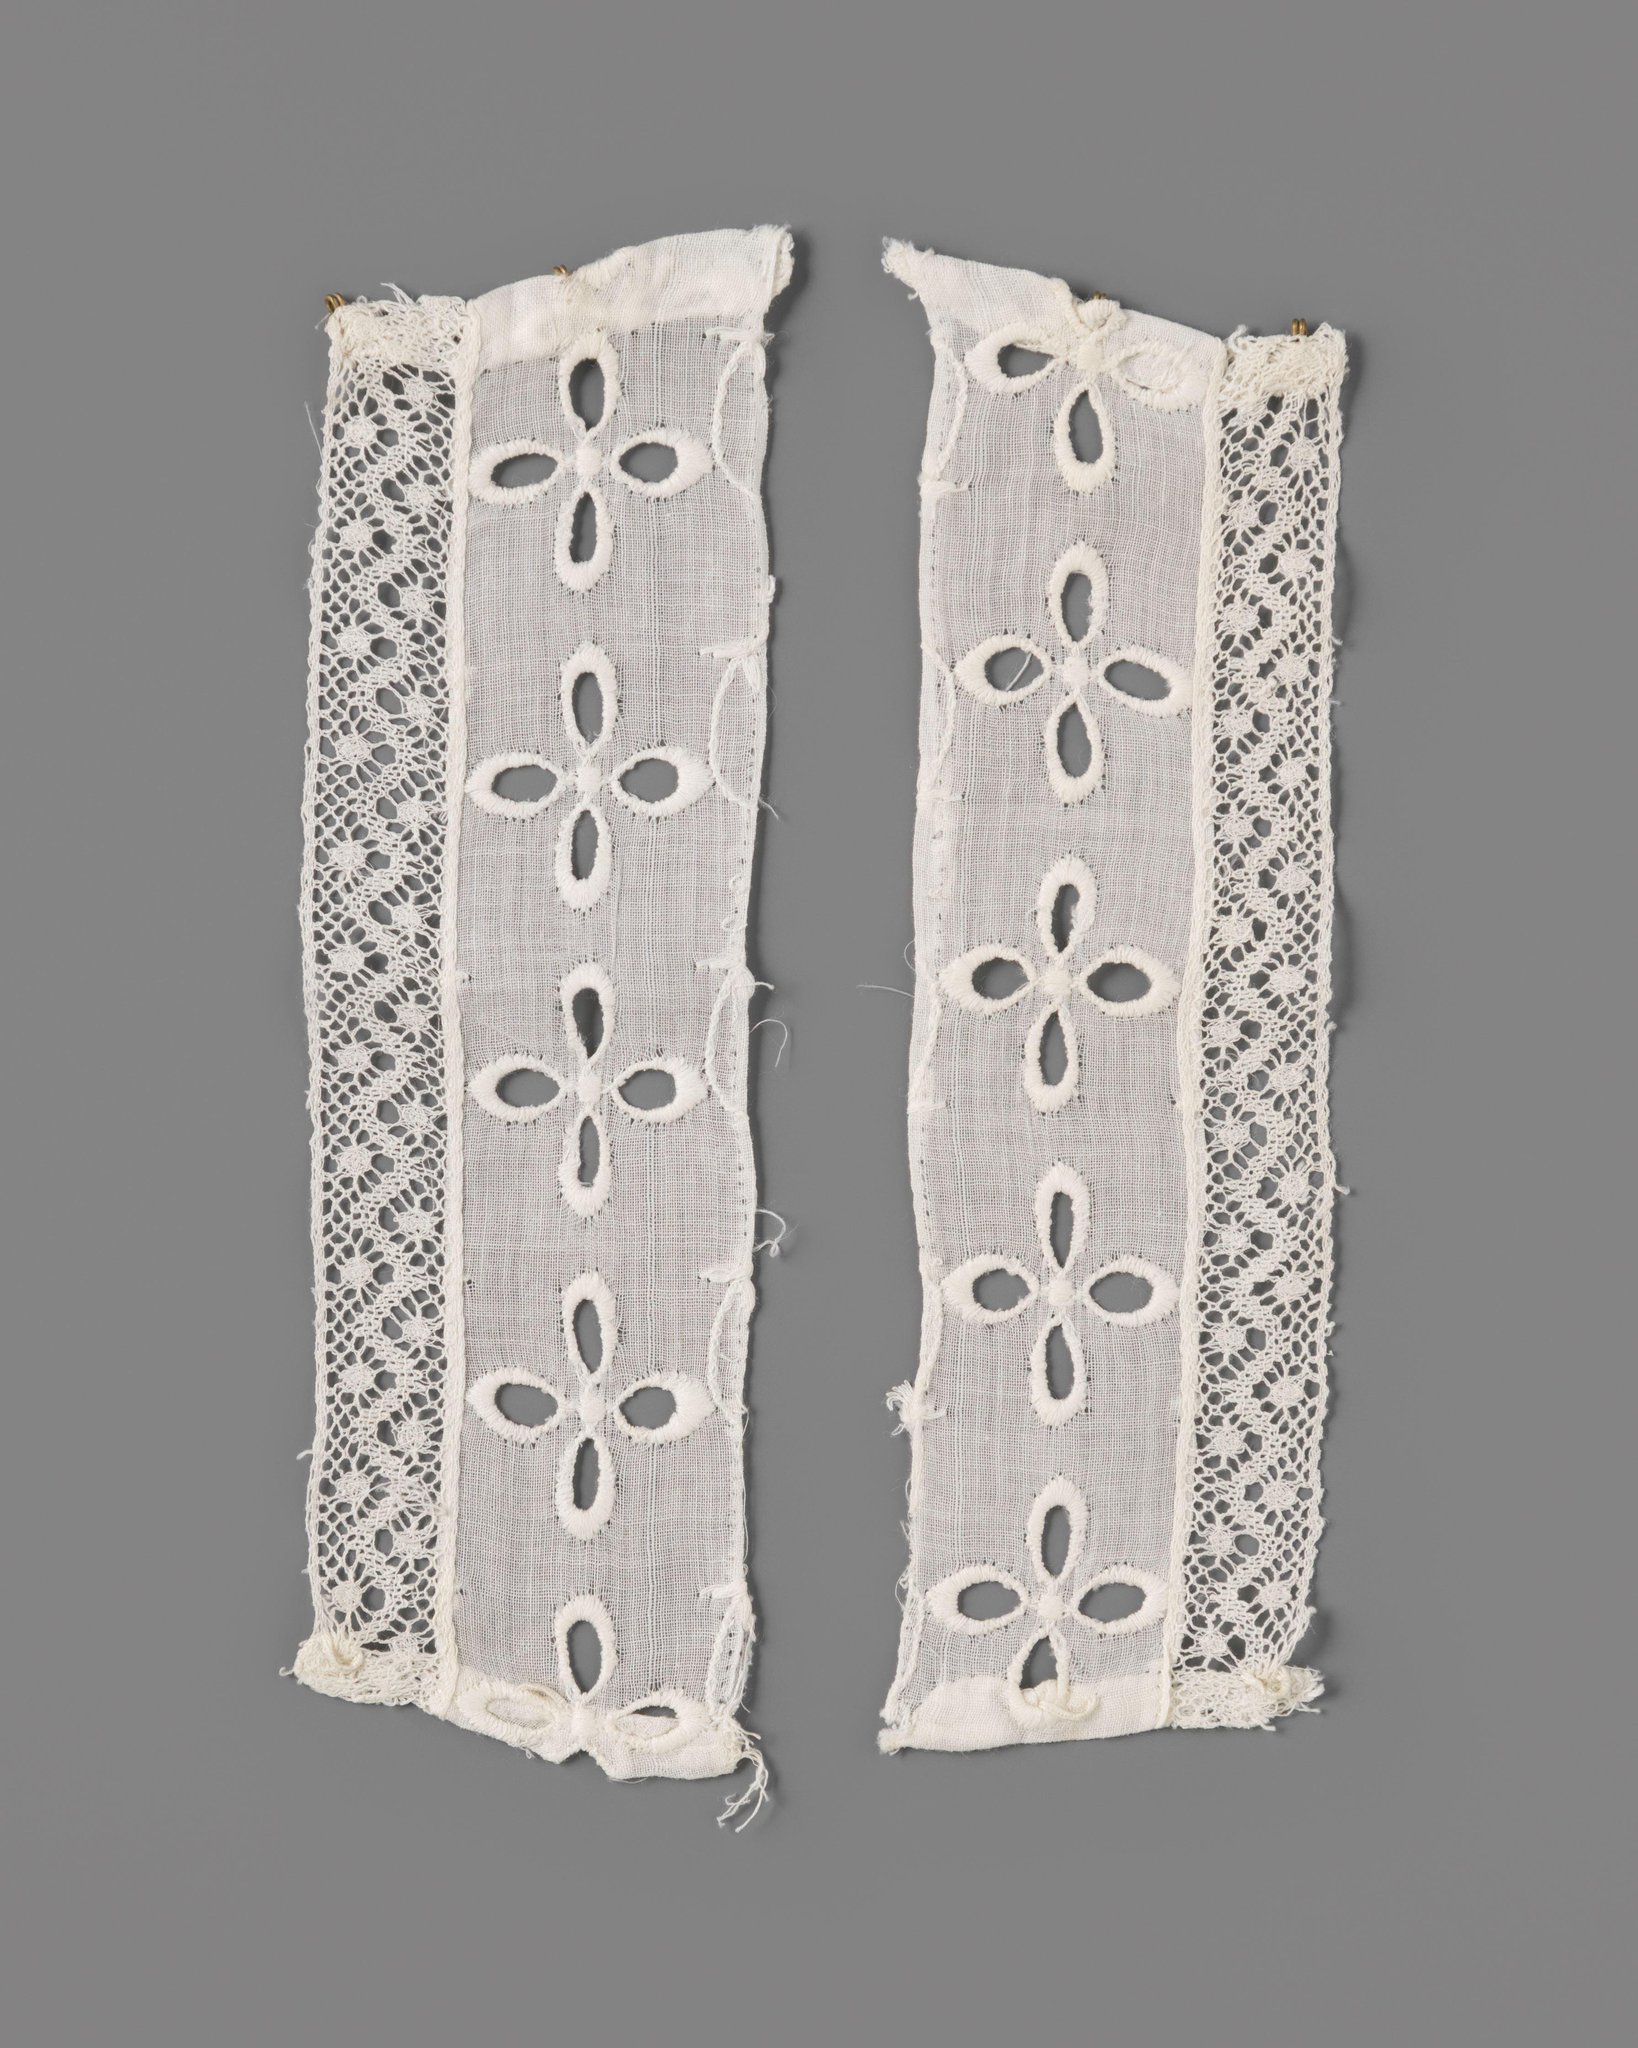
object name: cuff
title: Manchet van batist met Engels borduurwerk en een strook machinale kant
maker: Anonymous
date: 1880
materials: textile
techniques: english embroidery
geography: amsterdam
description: Manchet van batist met een sluiting van twee haken en ogen. Het batist is versierd met Engels borduurwerk in de vorm van vierbladige bloemen. Aan de manchet is een strook machinaal kant bevestigd.